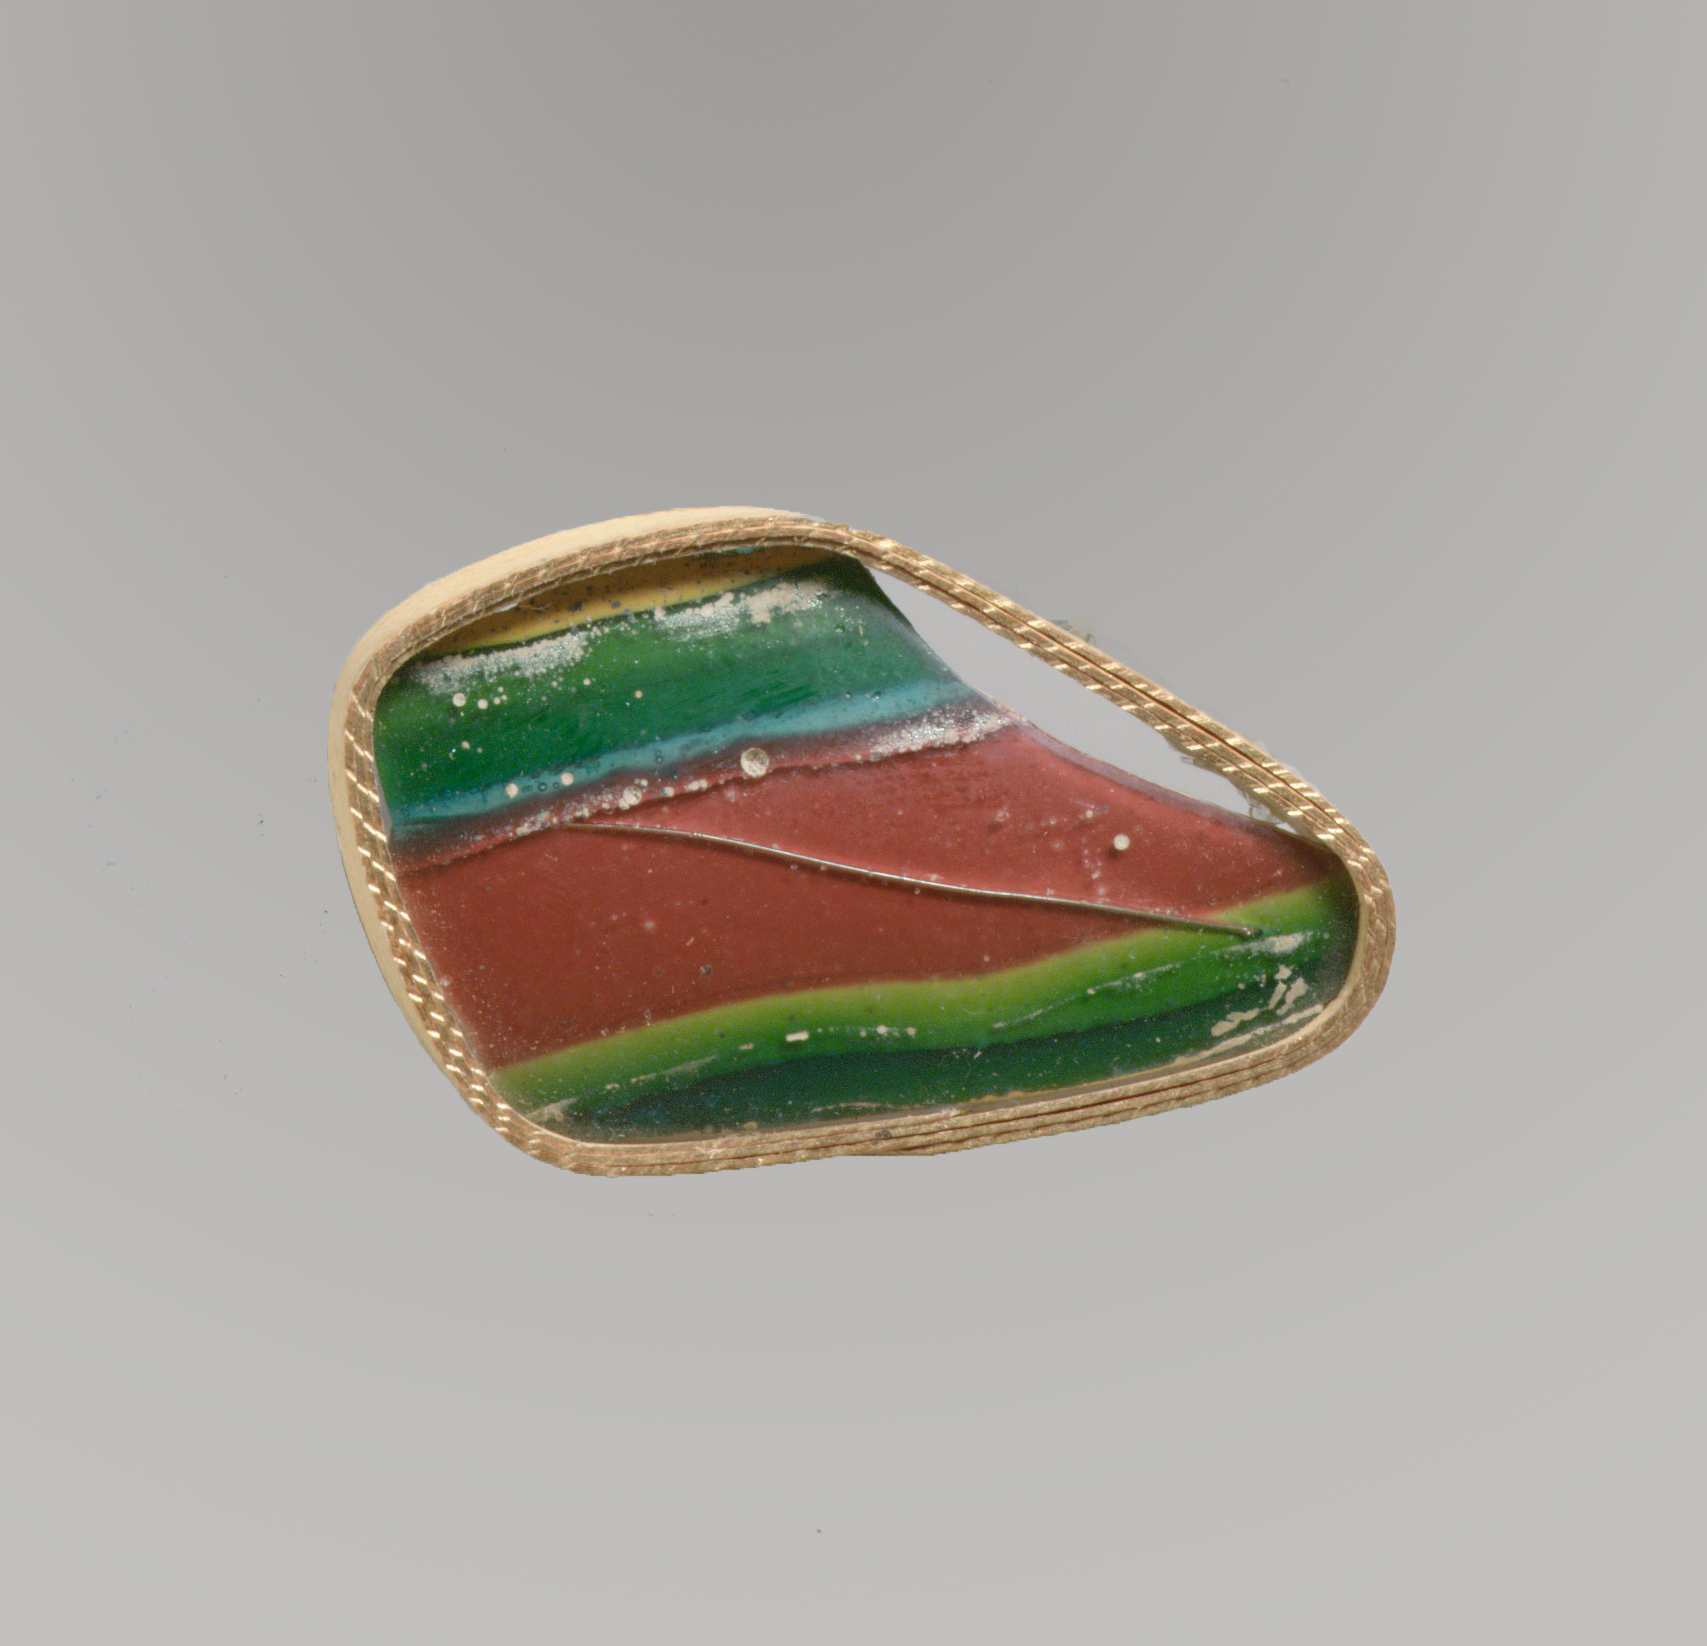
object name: fragment, striped mosaic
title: Glass striped mosaic bowl fragment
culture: roman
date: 34 BCE-33 CE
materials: glass